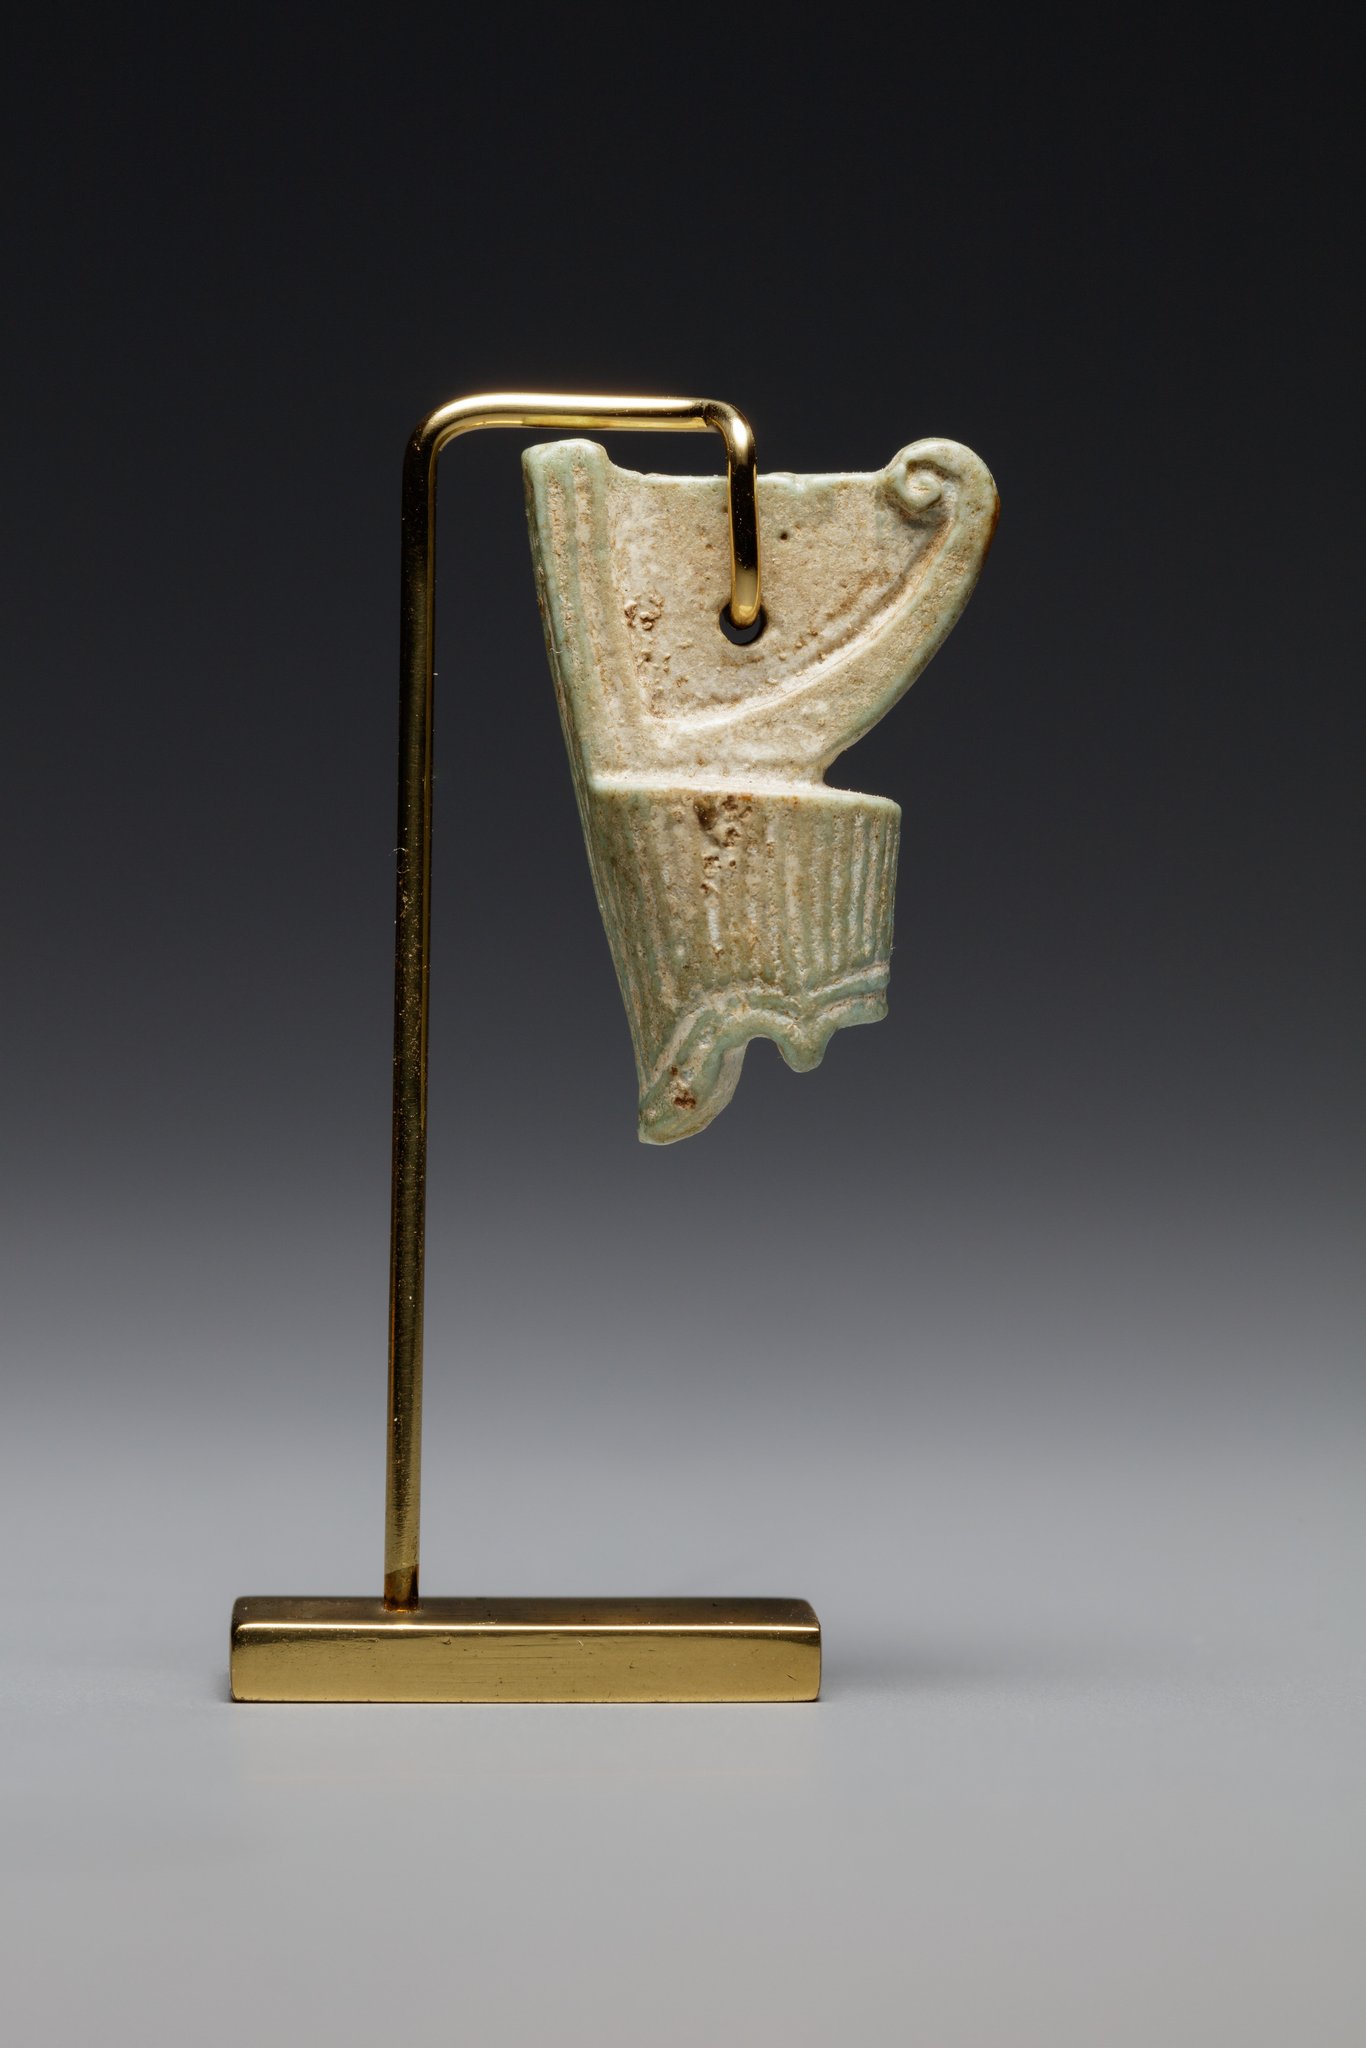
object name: amulet, crown of lower egypt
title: Amulet: Crown of Lower Egypt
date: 664-332 BCE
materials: faience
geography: egypt